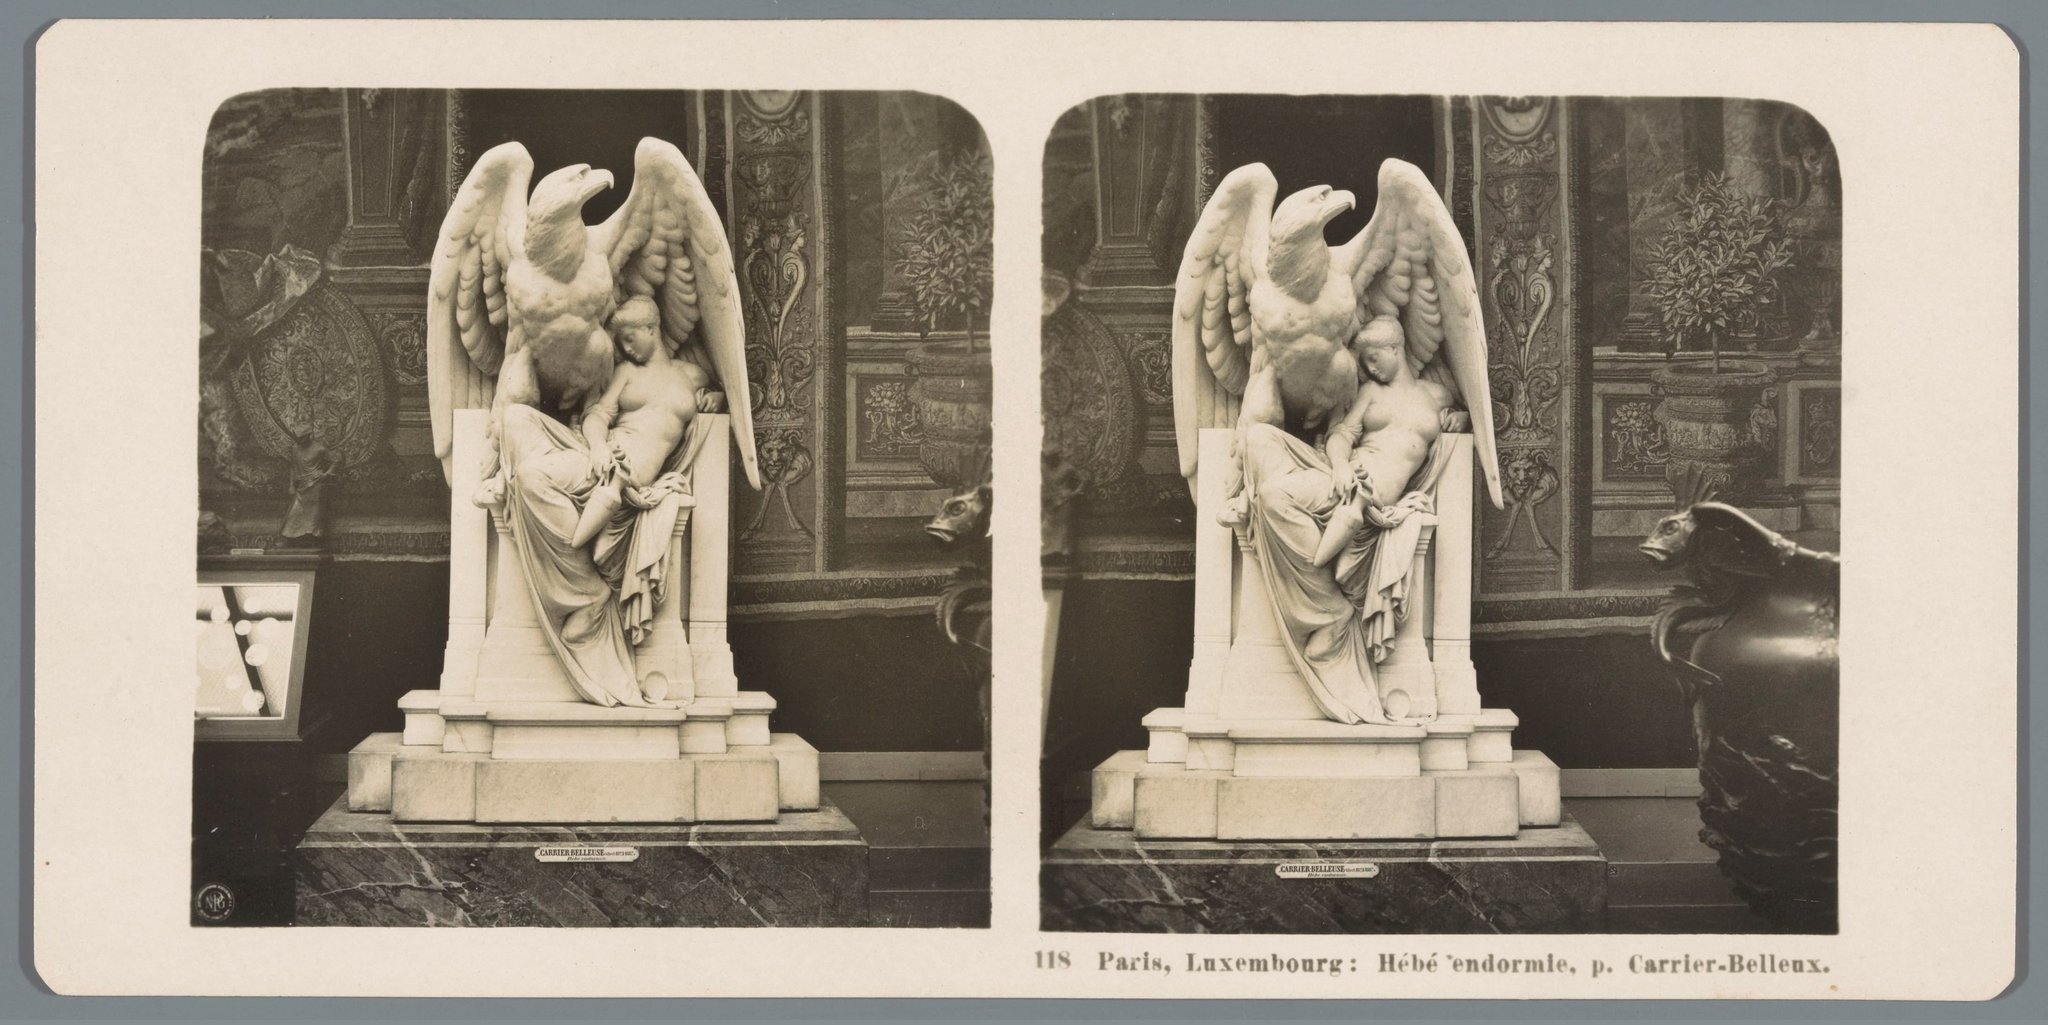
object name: stereograph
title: Paris, Luxembourg: Hébé endormie, p. Carrier-Belleux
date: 1895-1905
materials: cardboard, photographic support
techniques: gelatin silver print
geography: musée du luxembourg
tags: (story of) hebe (juventas), permanent exhibition, museum, sculpture, attributes of jupiter: eagle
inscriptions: number: ‘118’, inscription: ‘NPG’